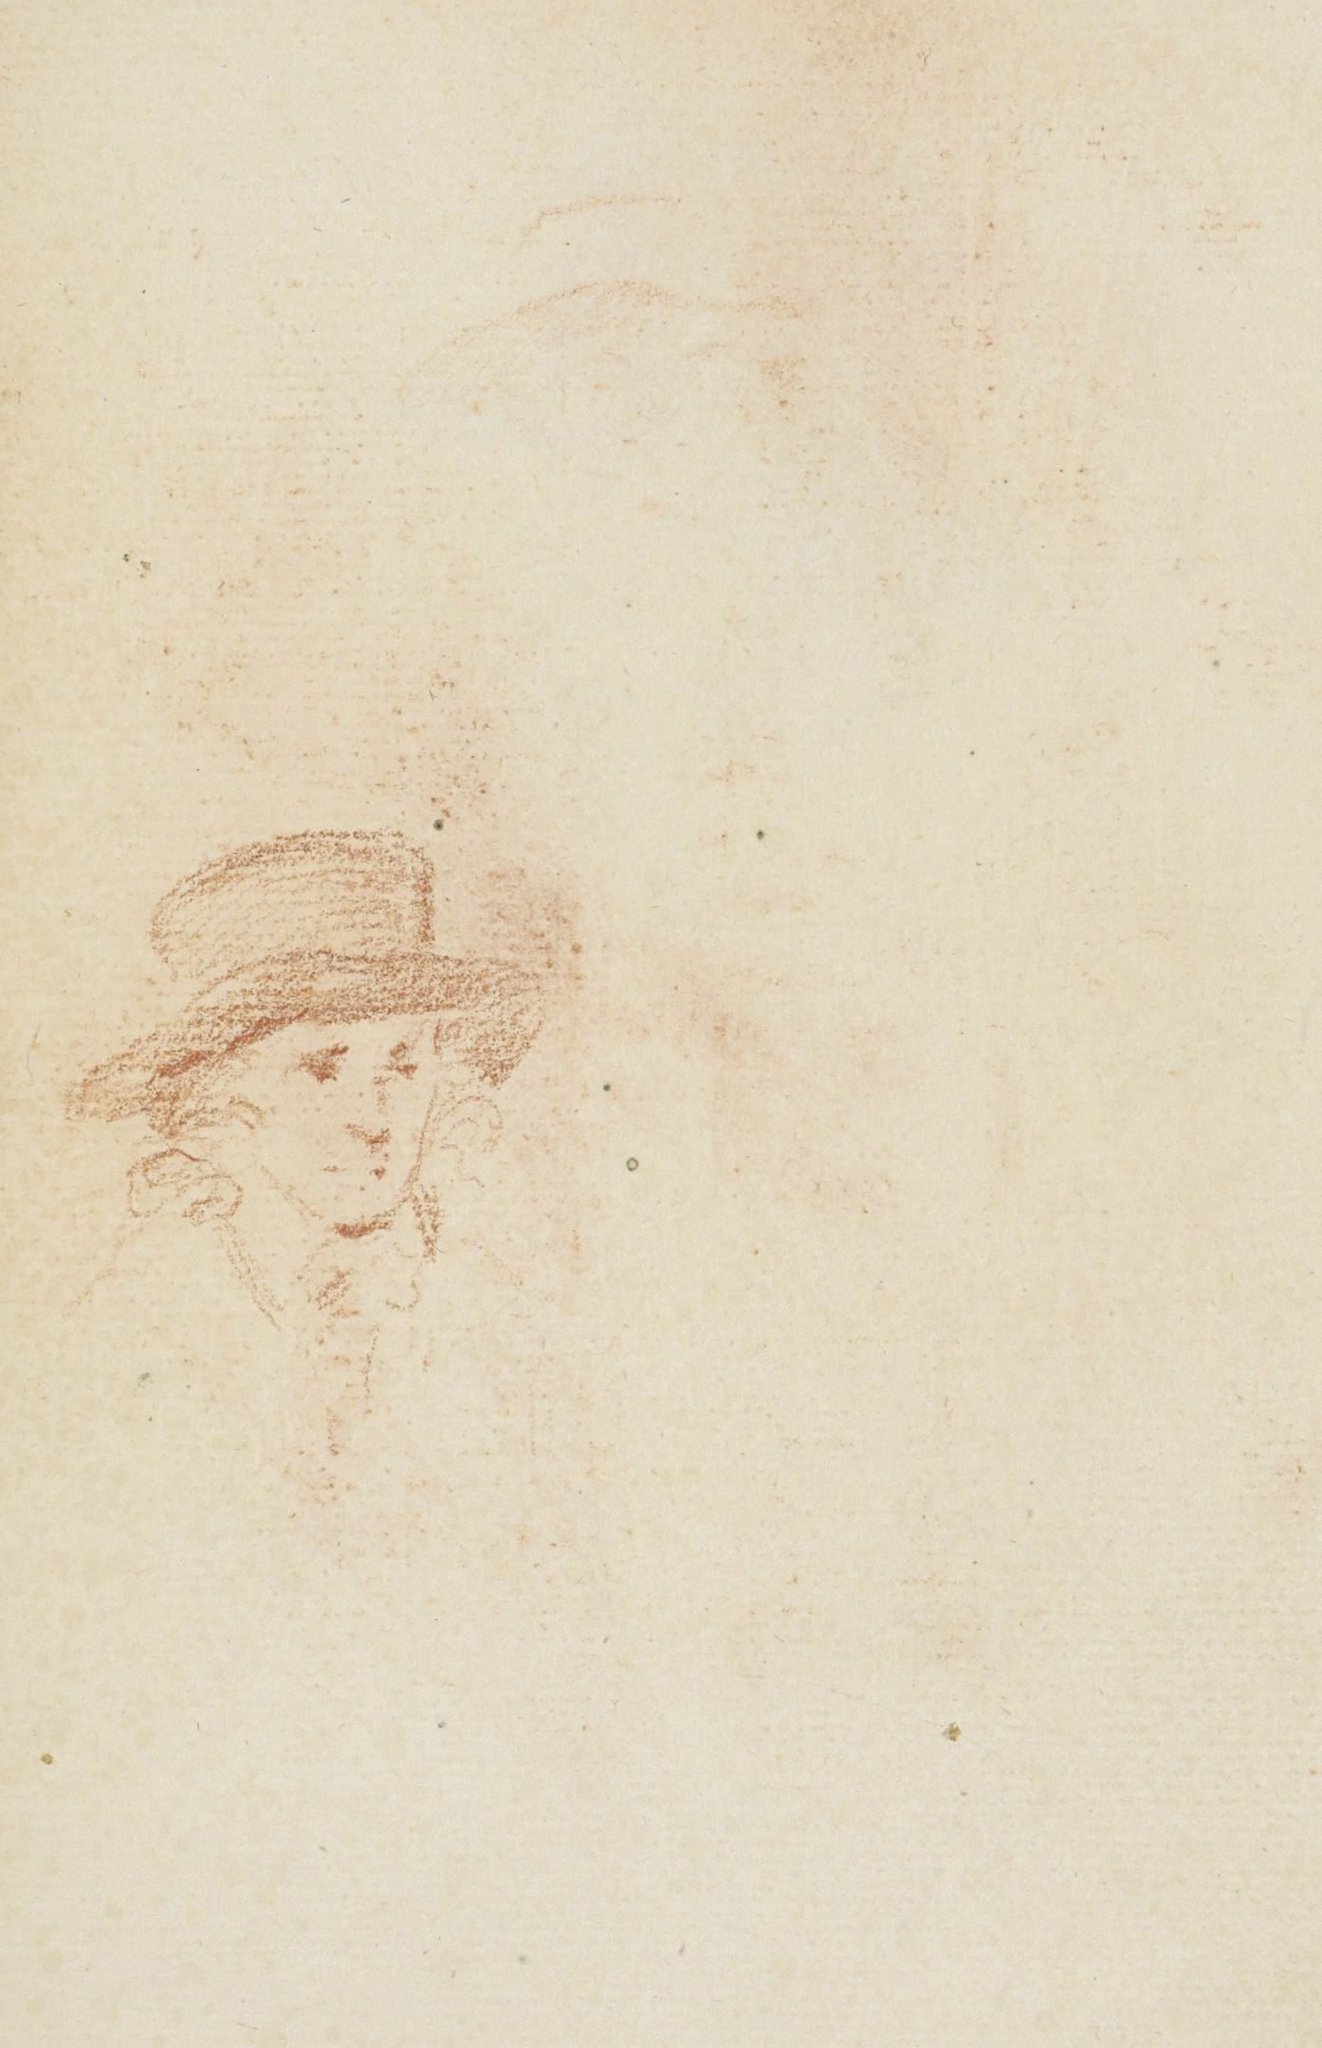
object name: sketchbook leaf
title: Kop van een man met een hoge hoed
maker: jacob perkois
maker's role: draughtsman, print maker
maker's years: 1756-1804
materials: chalk, paper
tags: head (human)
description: Bladzijde 42 uit een schetsboek met 78 bladzijden.